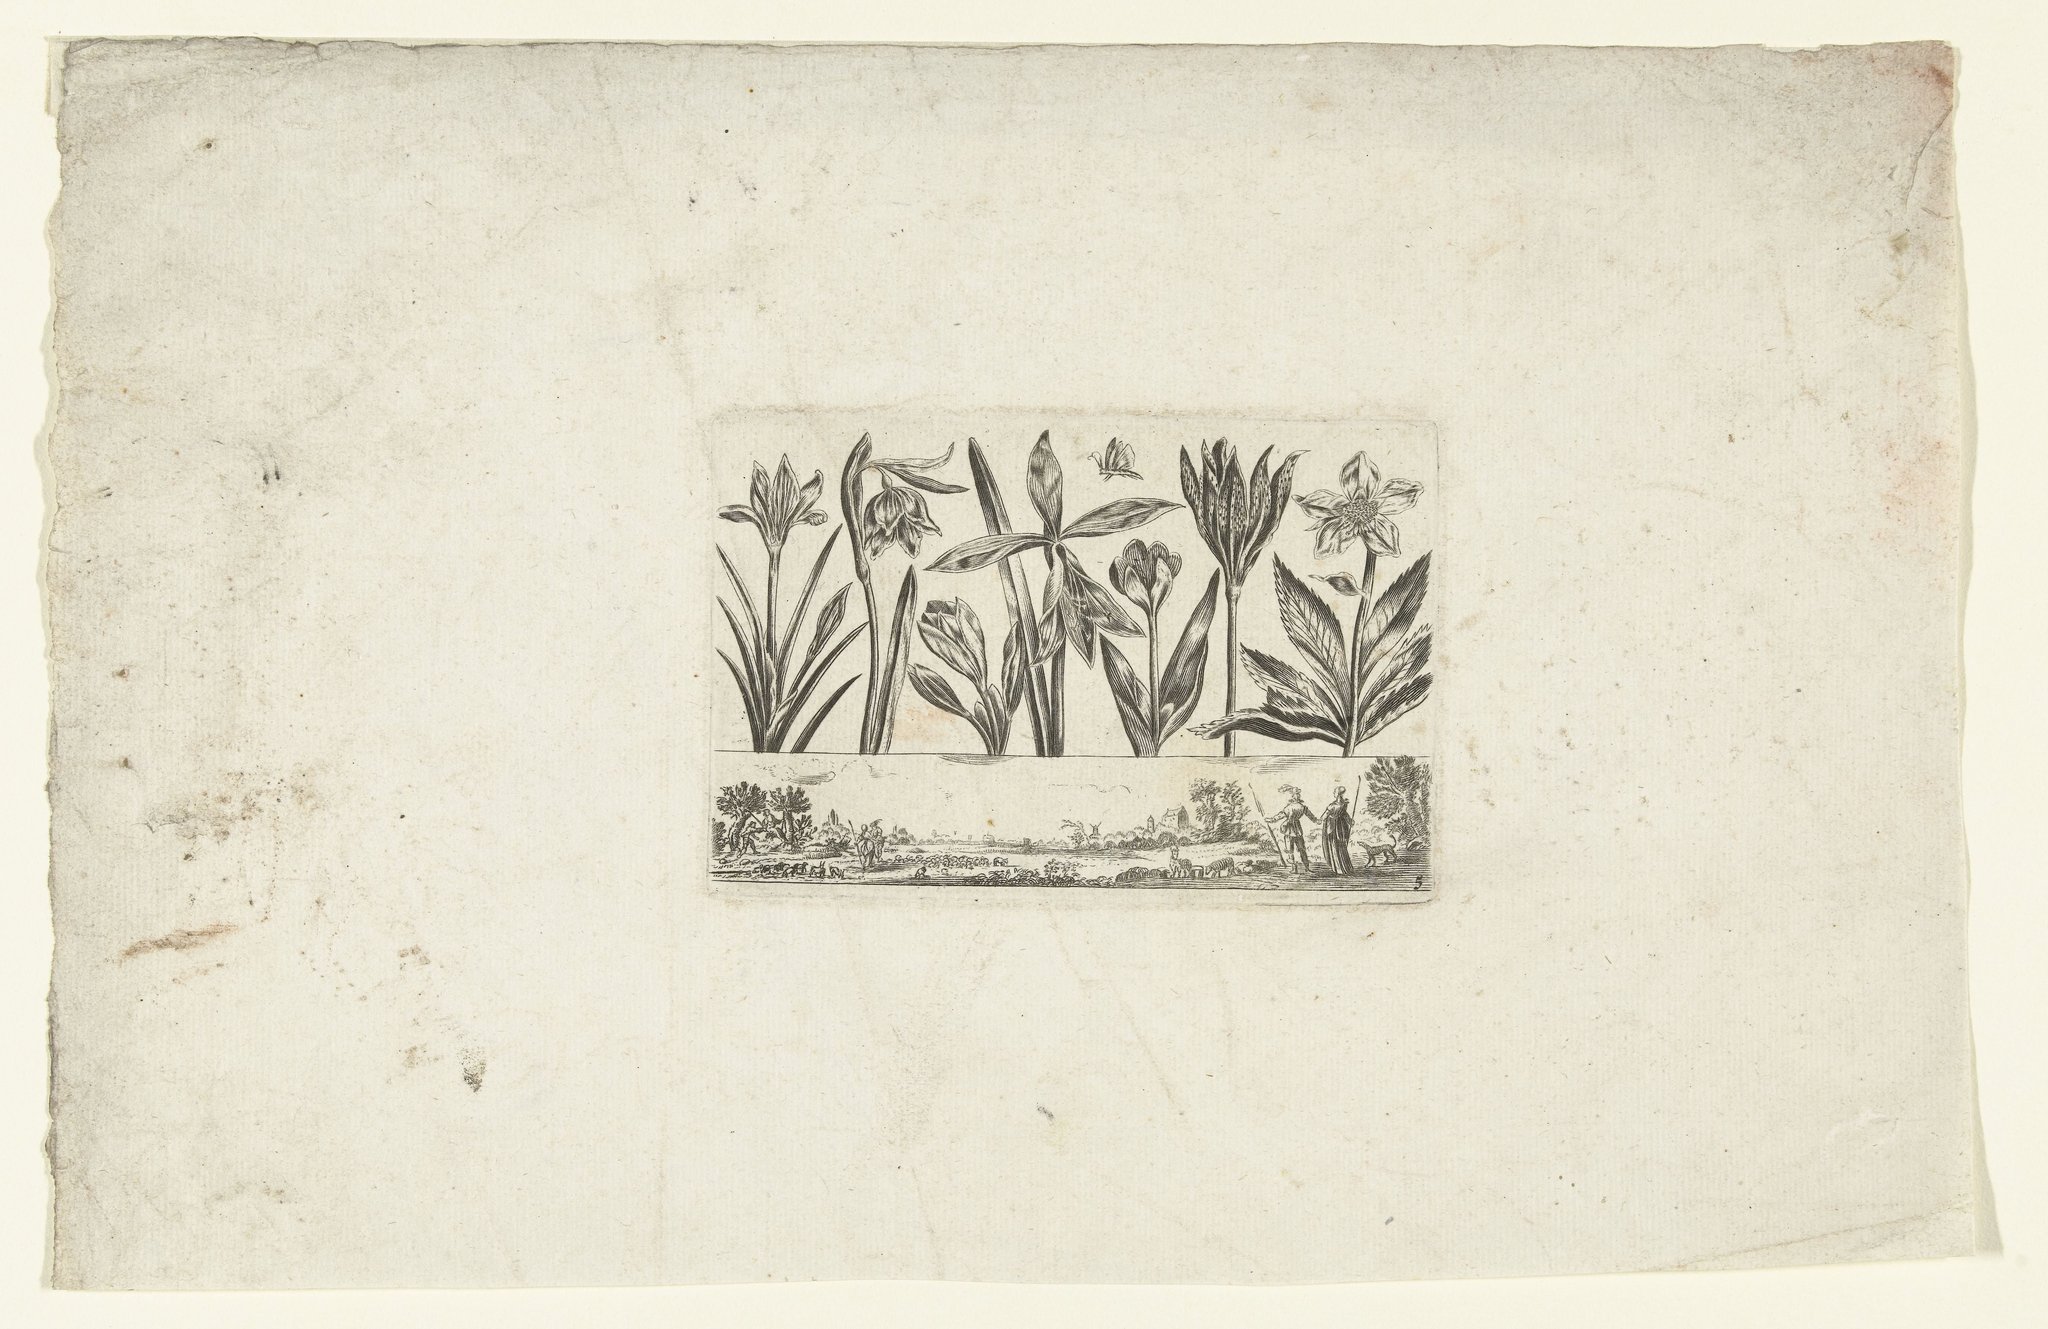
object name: ornament print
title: Bloemen en landschappen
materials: paper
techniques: etching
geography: netherlands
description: Linksboven staat een iris, rechtsonder staat een stel van achteren gezien en linksonder zit een vrouw op een schommel. Blad 5 uit serie van 7 bladen, genummerd 3-10, één blad heeft geen nummer. Tweede editie.